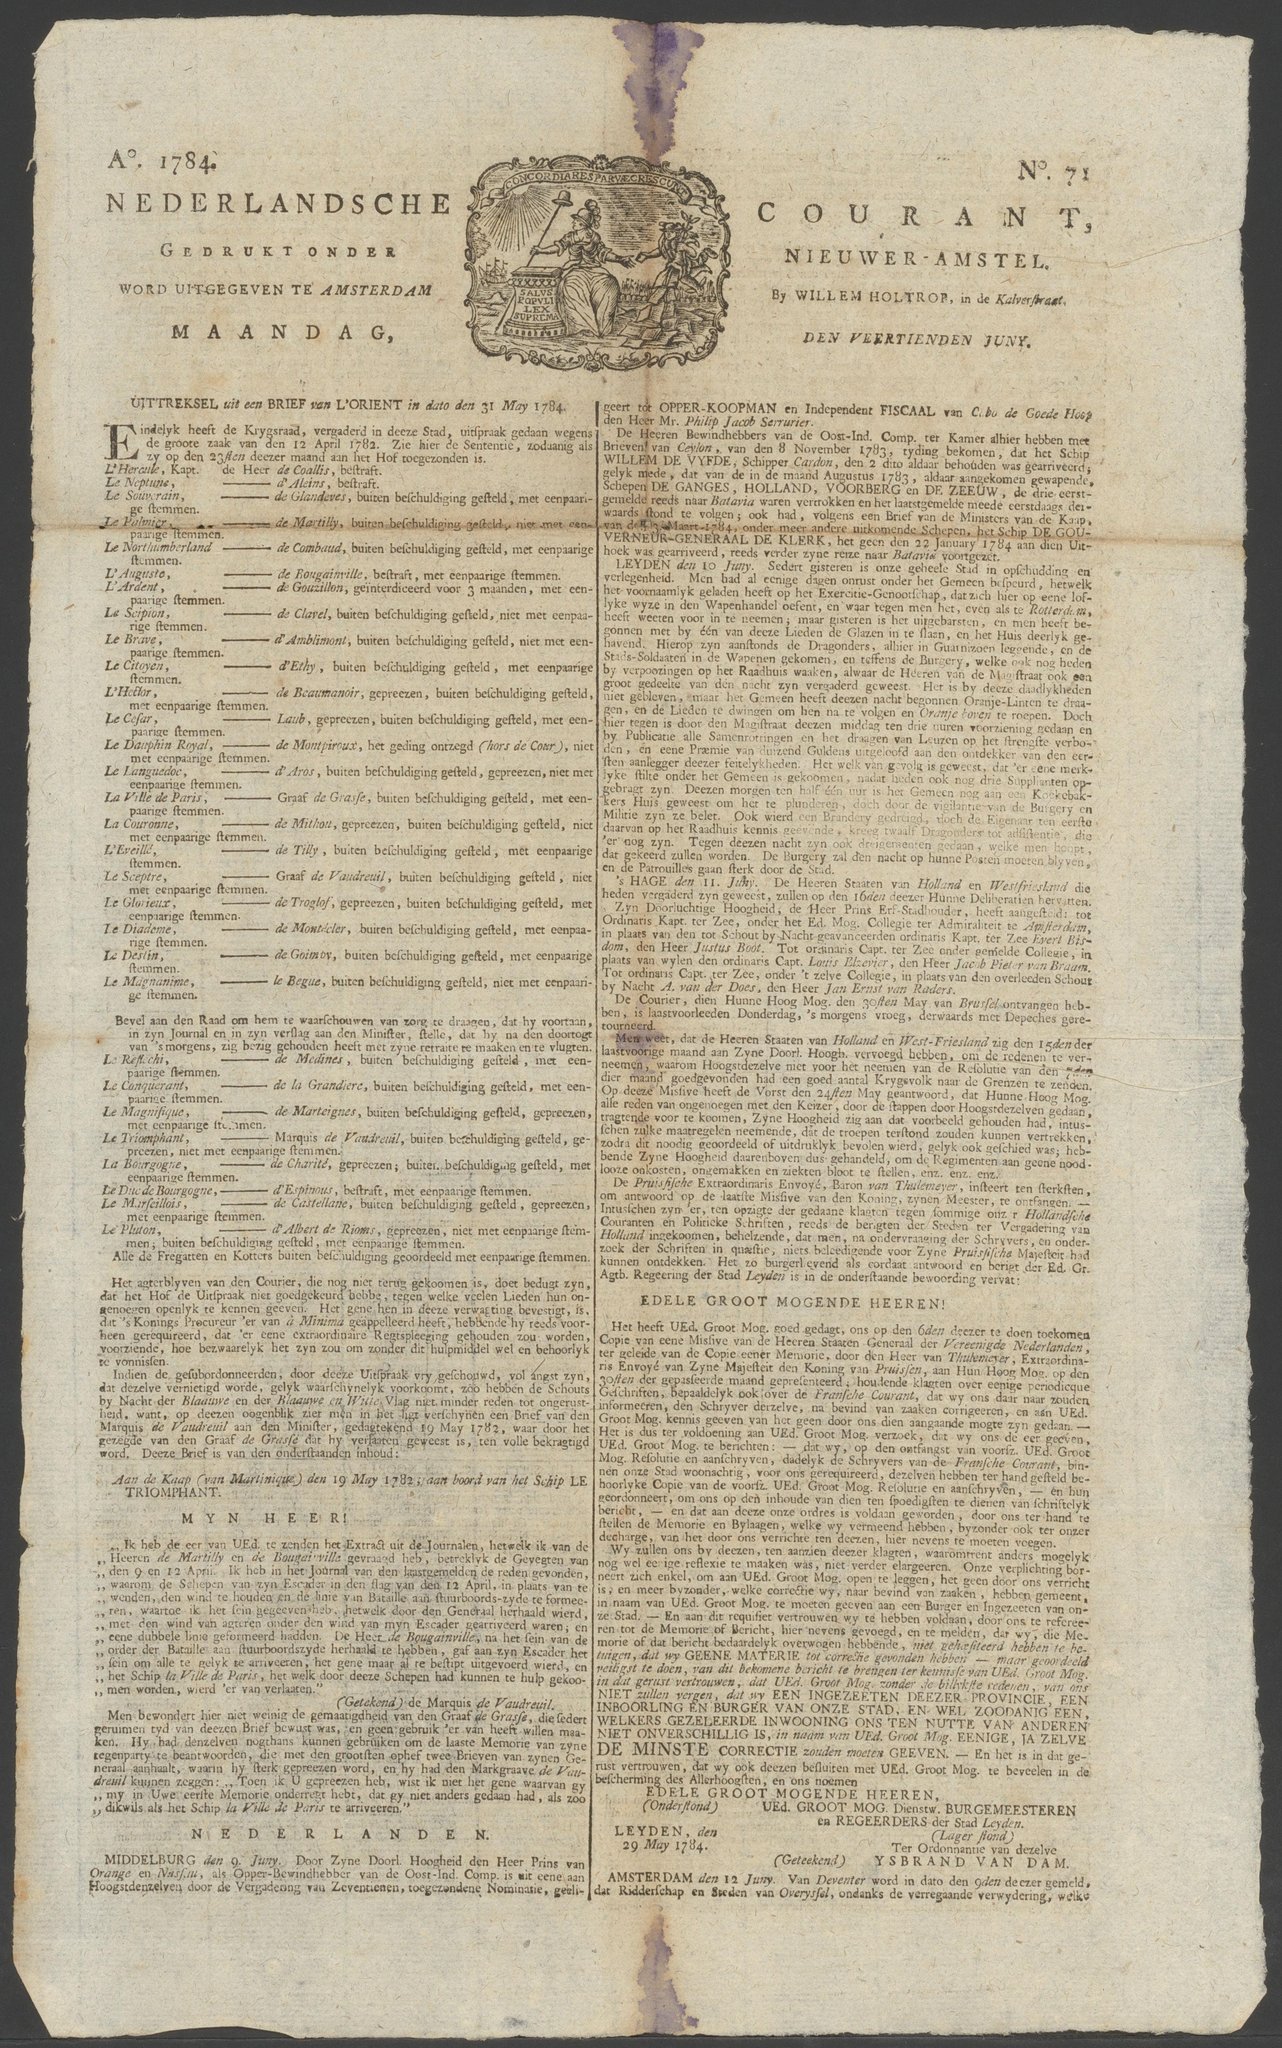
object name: newspaper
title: Nederlandsche Courant, 14 juni 1784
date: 1784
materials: paper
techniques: letterpress printing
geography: nieuwer-amstel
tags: newspaper, news-sheet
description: Exemplaar van de krant 'Nederlandsche Courant' van 14 juni 1784. Enkelbladig, beide zijden bedrukt. Bovenaan een vignet met de Vrijheid en Mercurius. Onderwerpsrubrieken binnen de Atlas Zeden en Gewoonten: Regeering, Officieele Nieuwsbladen.